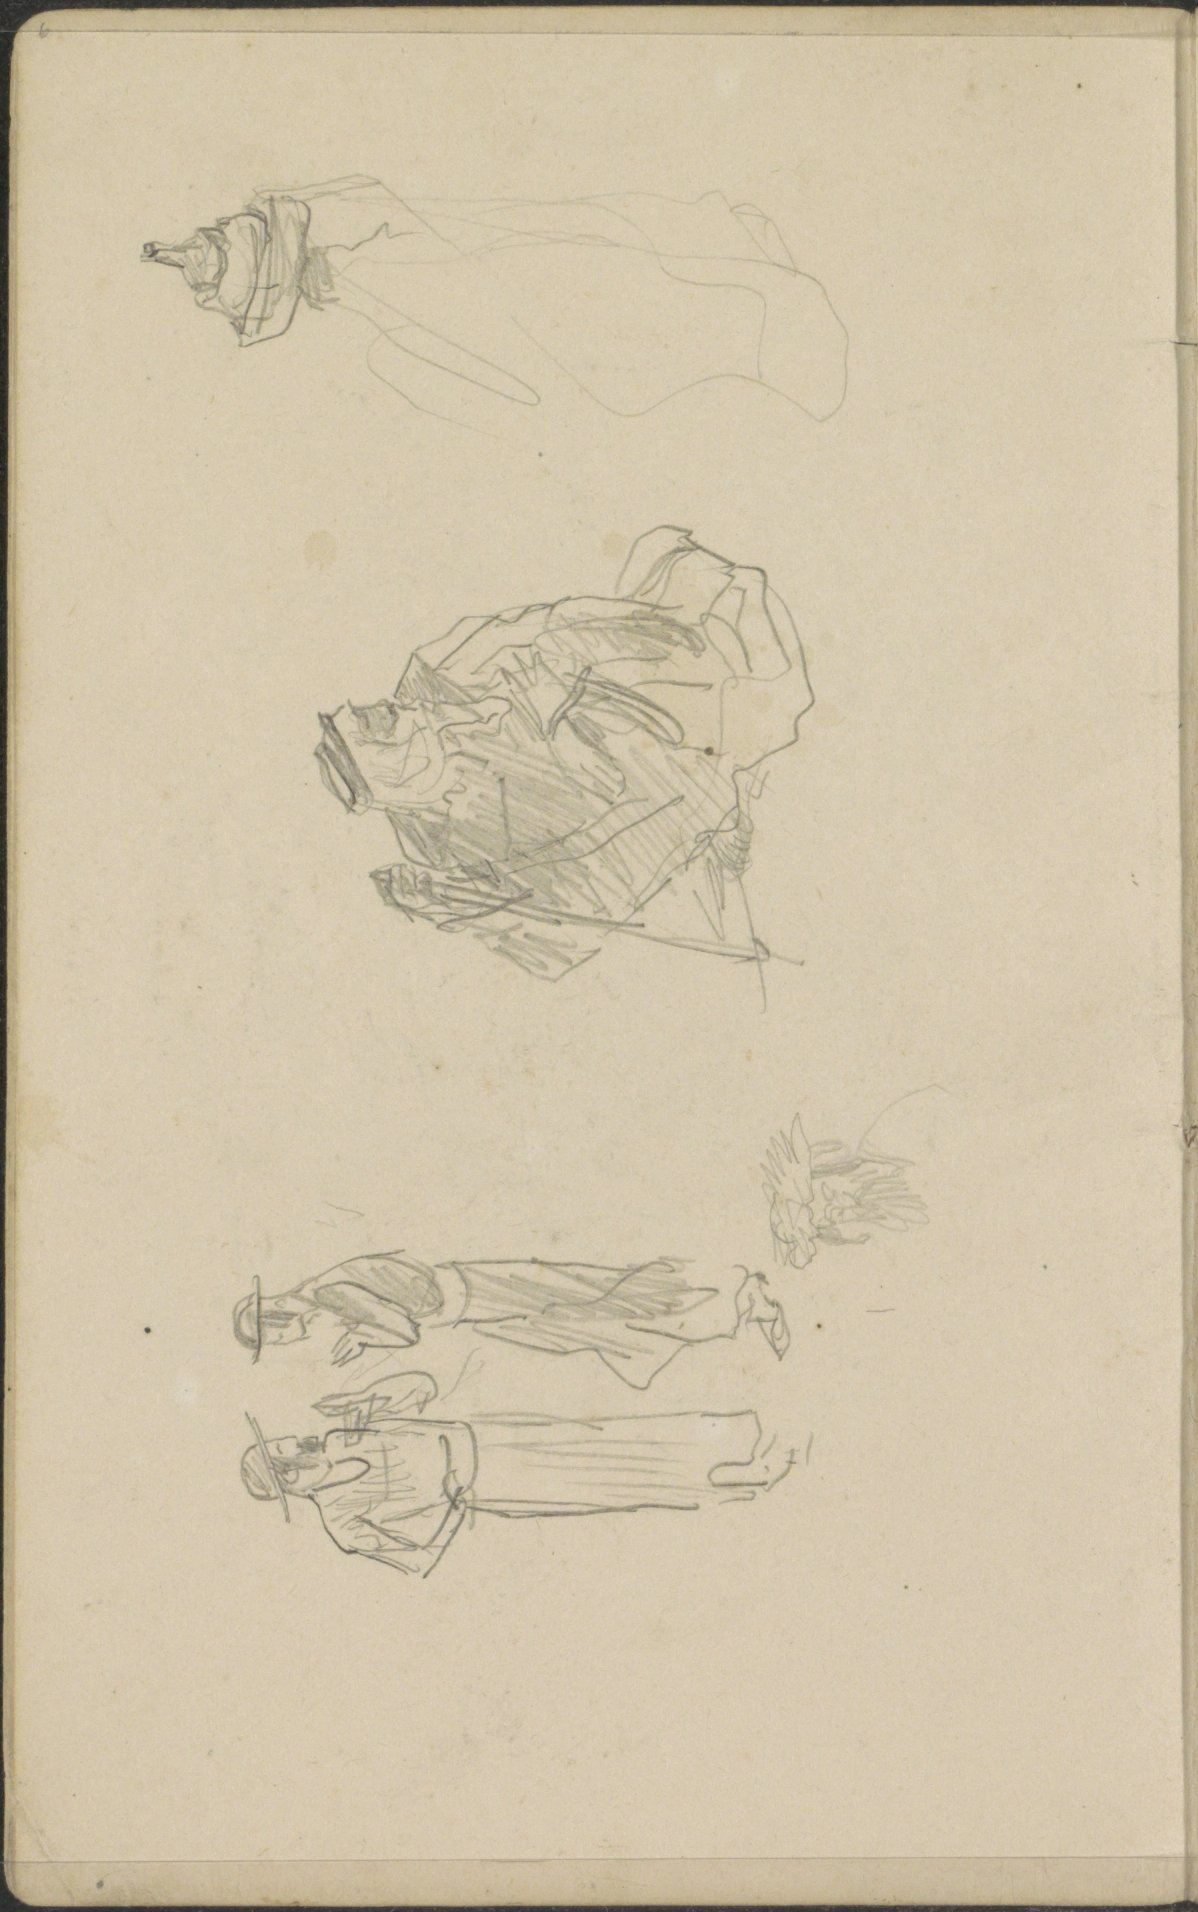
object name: sketchbook leaf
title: Twee Joden en een zittende Arabier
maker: marius bauer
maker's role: draughtsman, print maker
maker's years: 1867-1932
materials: paper, pencil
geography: jerusalem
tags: sitting figure, africans, folk costume, regional costume, the jews, jewish life, carrying something on the head or on the shoulders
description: De figuren dragen traditioneel kostuum. Pagina 6 uit een schetsboek met 36 bladen.